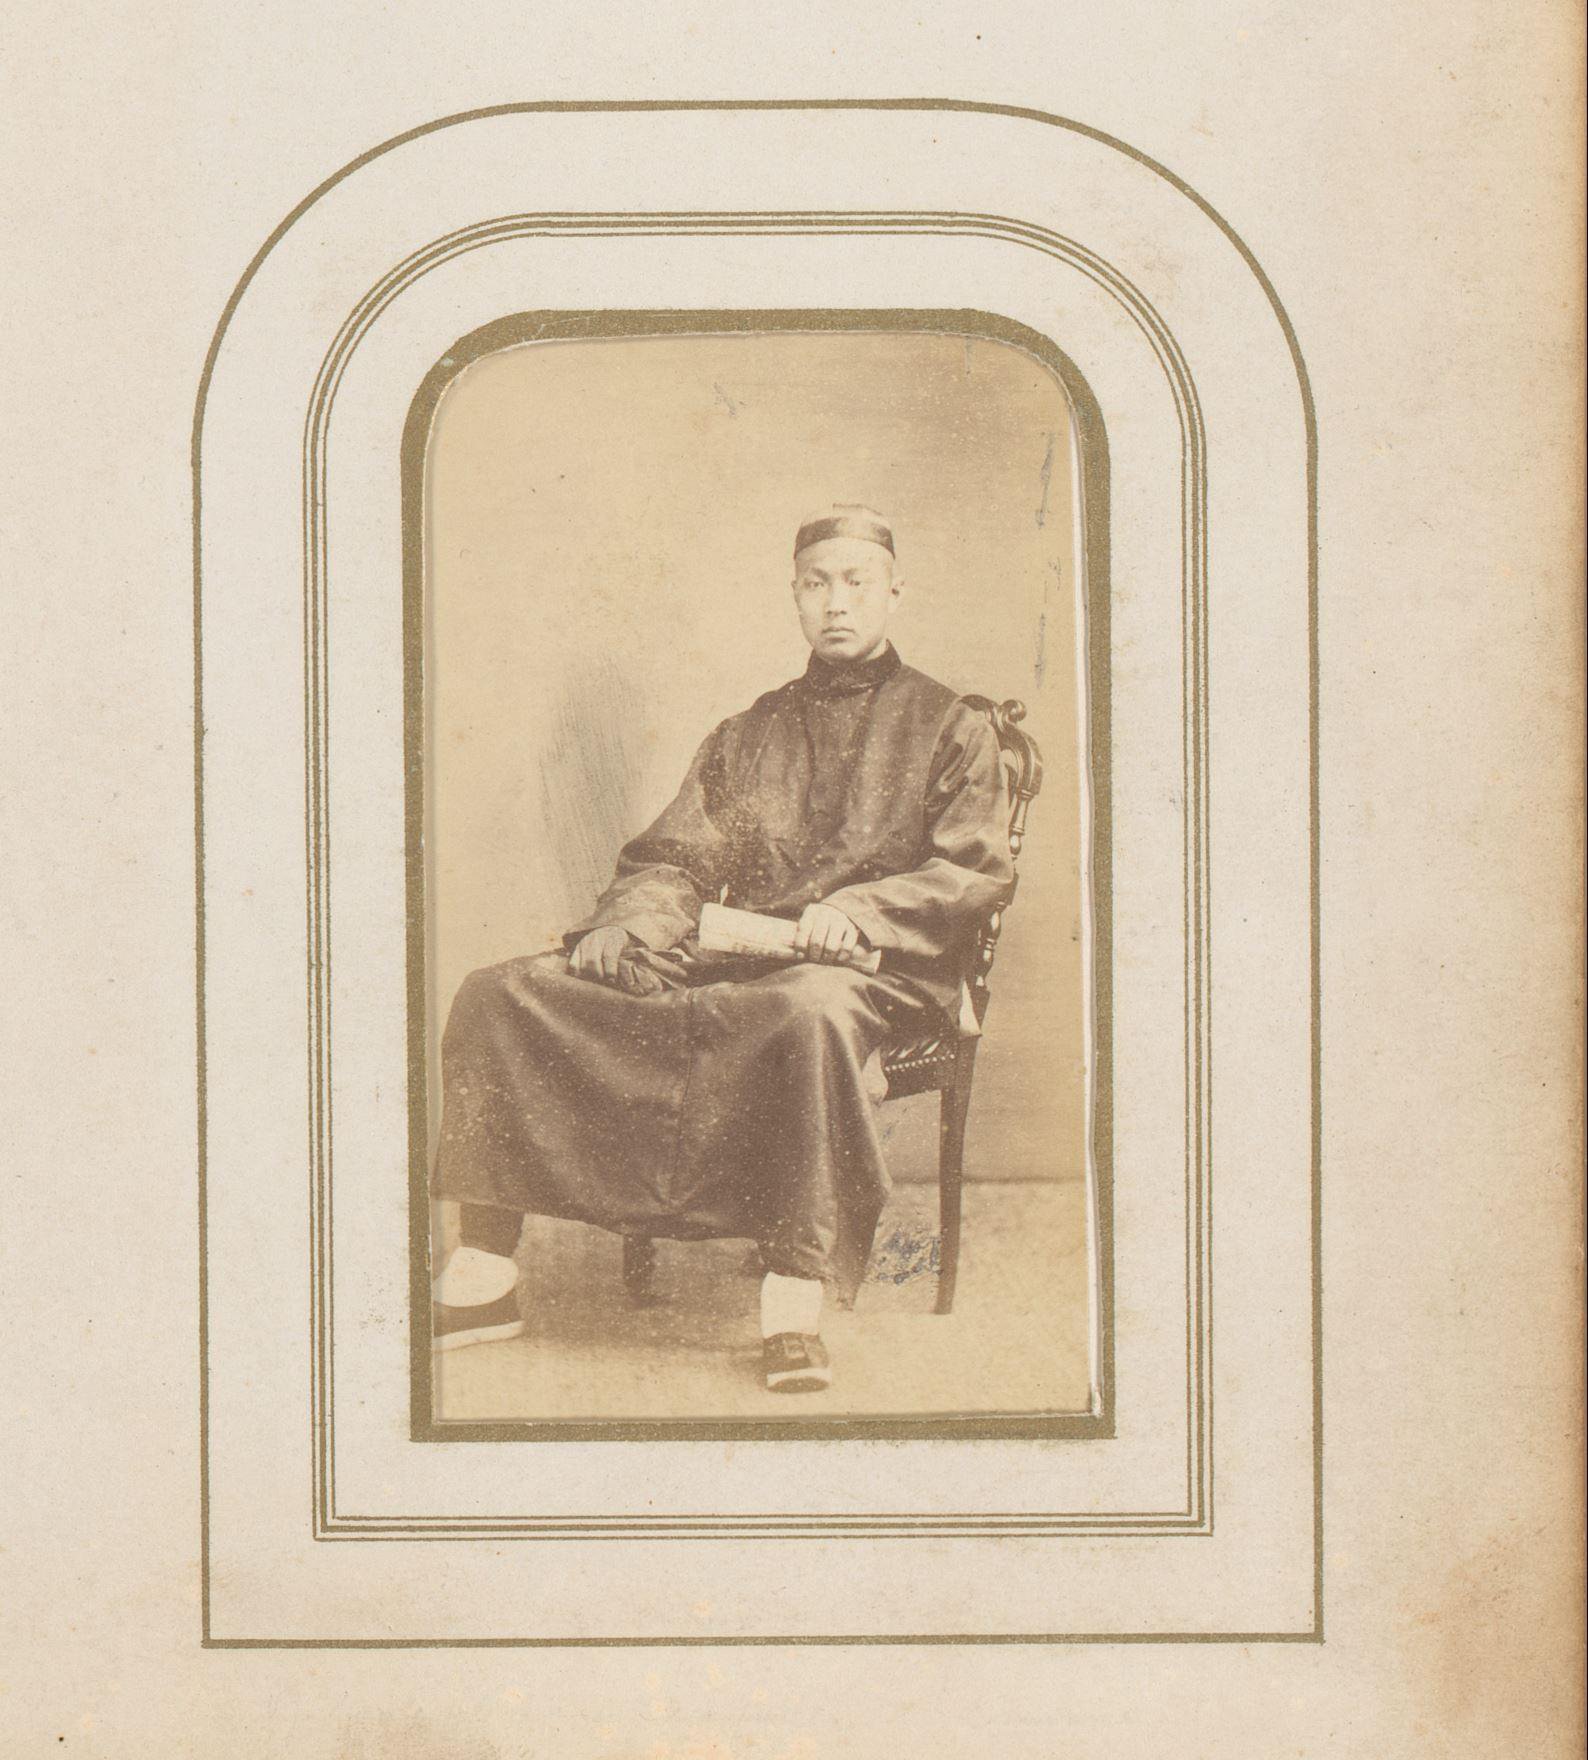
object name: photograph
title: Portret van een zittende man met hoed en handschoenen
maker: Anonymous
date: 1860-1890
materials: cardboard, photographic support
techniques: albumen print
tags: sitting figure, gloves, mittens, etc., historical persons